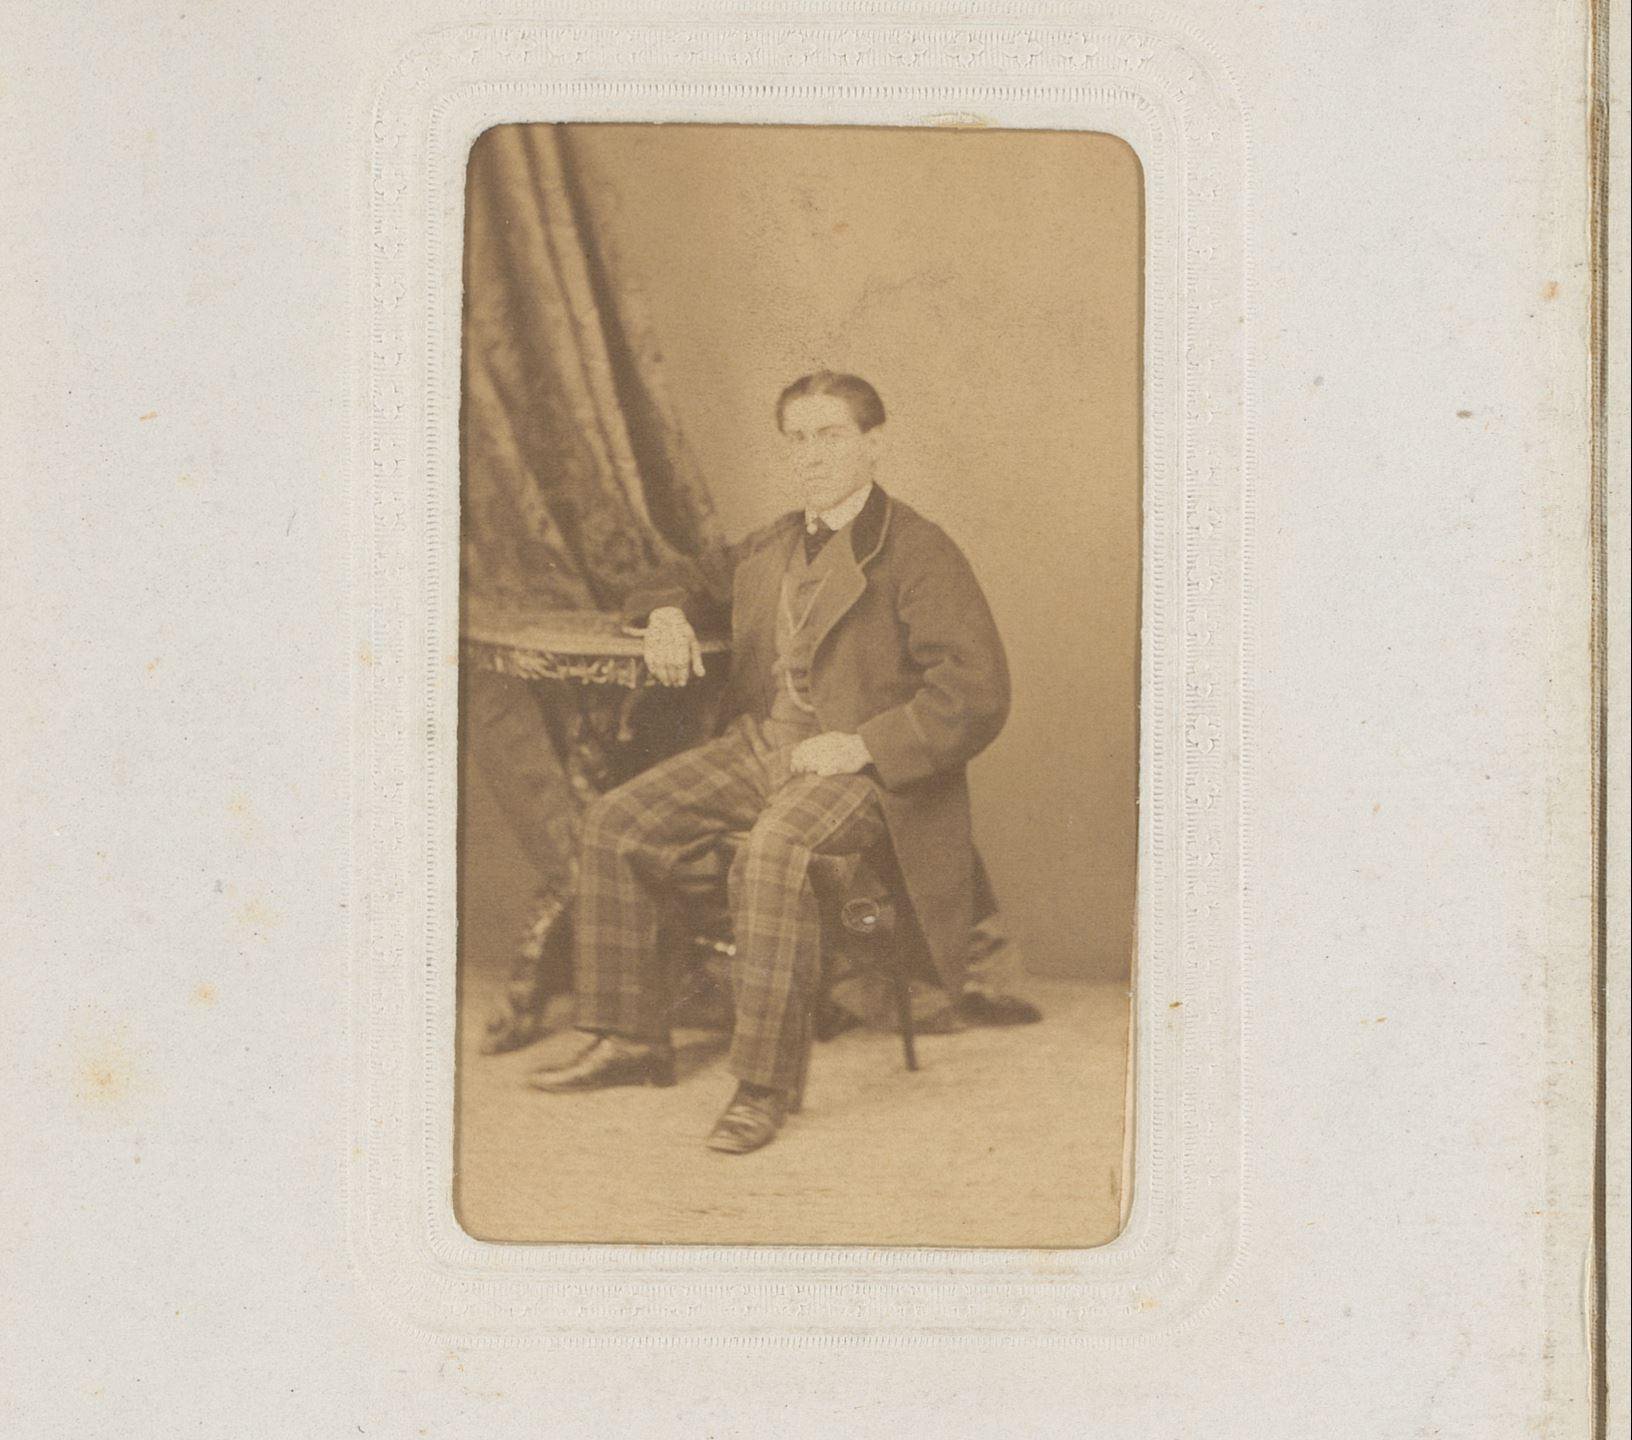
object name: carte de visite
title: Portret van een zittende man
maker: josé martínez sanchez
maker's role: fotograaf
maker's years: 1807-1874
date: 1850-1874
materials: cardboard, photographic support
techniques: albumen print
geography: madrid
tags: sitting figure, historical persons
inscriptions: inscription: ‘Fotografia/ de J. Martinez/ Sanchez/ 1 y 3, Puerta del Sol’